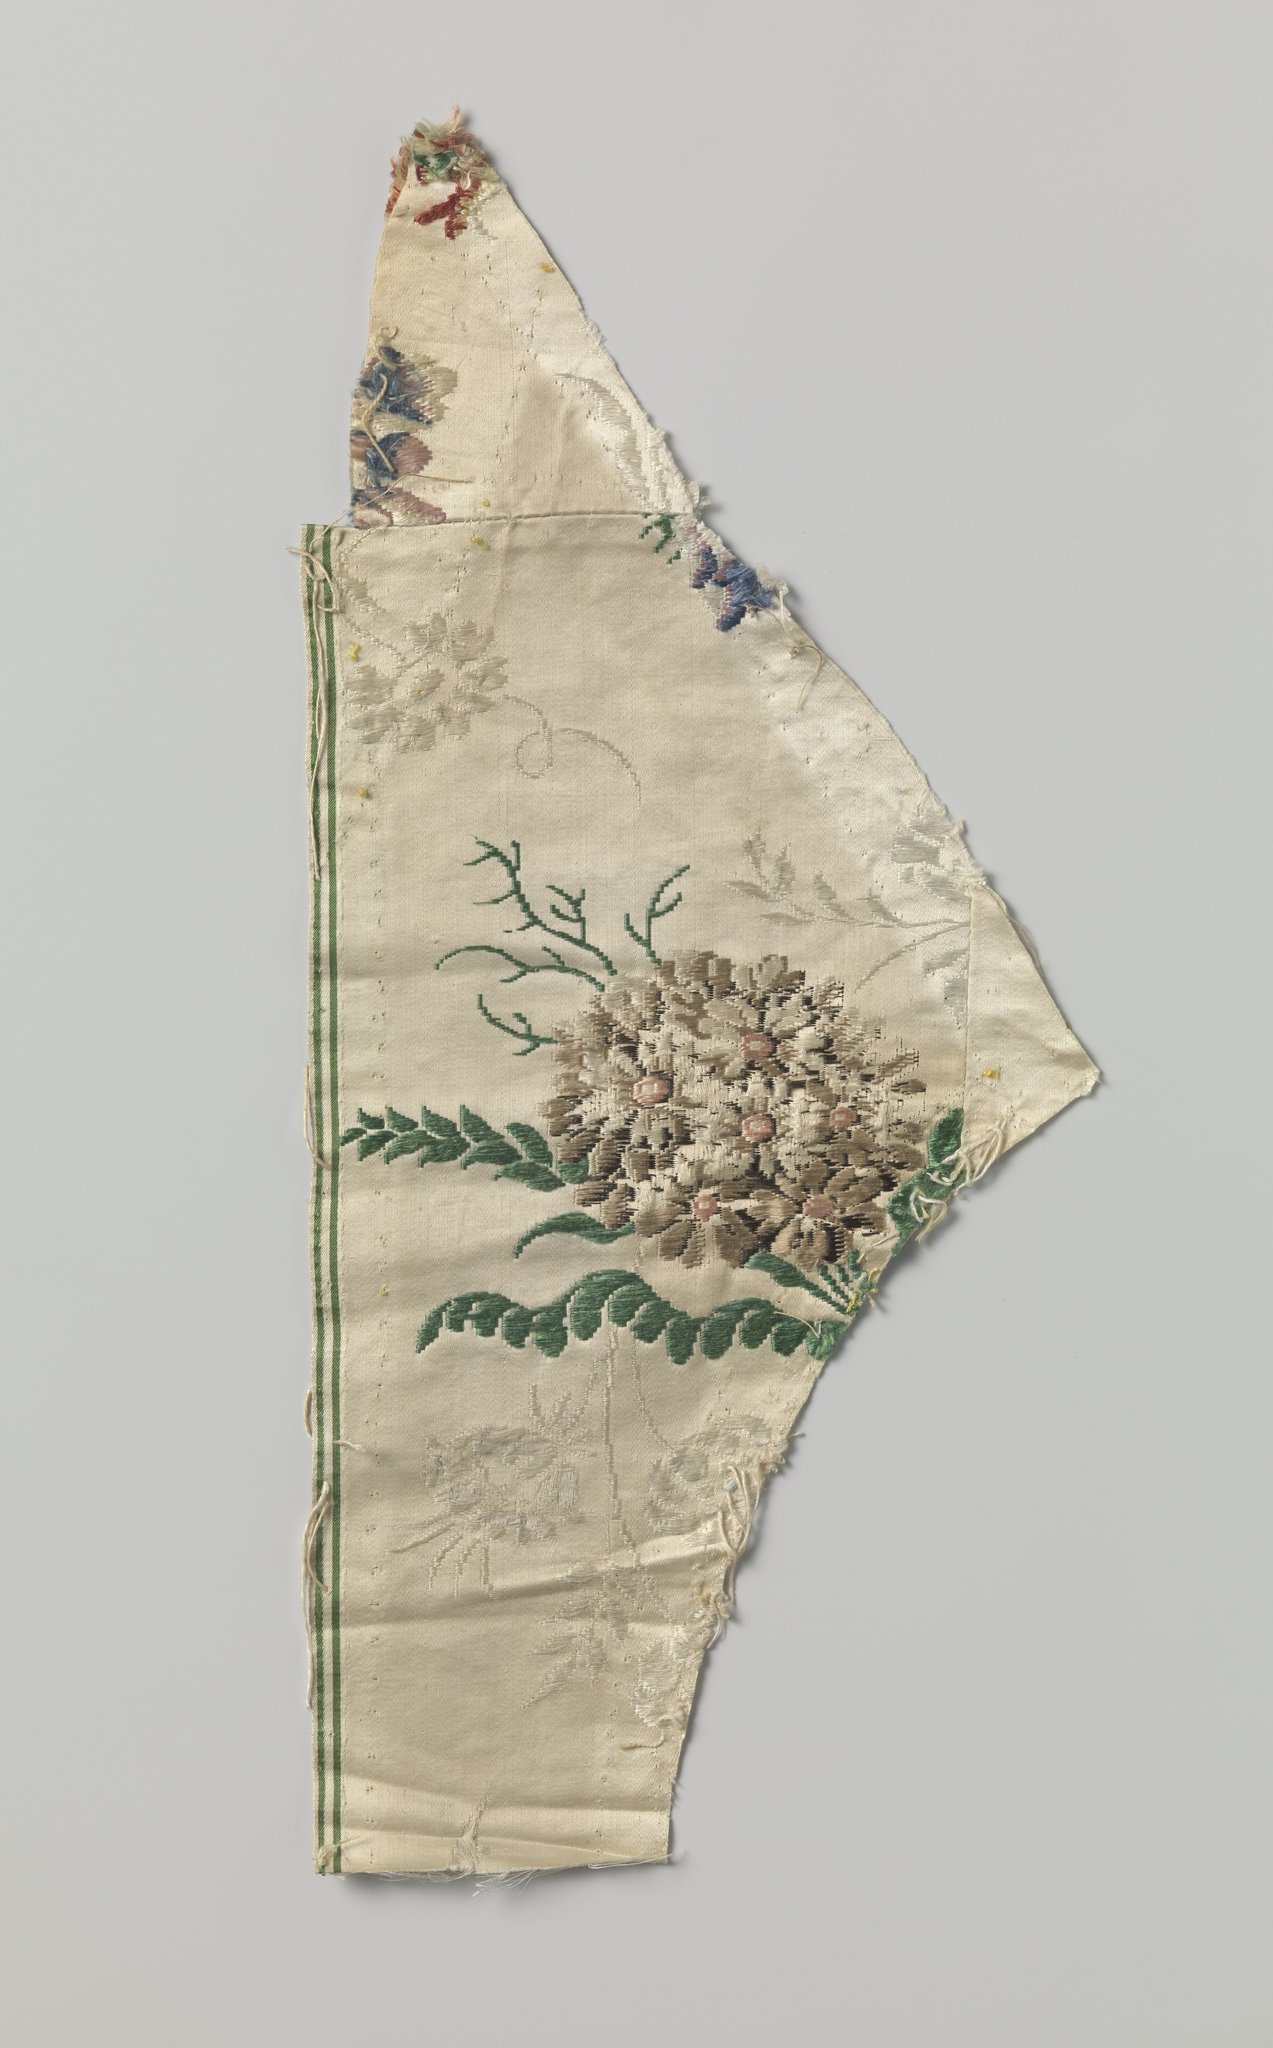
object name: fragment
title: Fragment gebrocheerde zijde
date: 1775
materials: silk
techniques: brocade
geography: europe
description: Fragment zijdeweefsel. Een crèmekleurige satijnen grond heeft witte bloemslingers en een meerkleurig boeket bloemen met bladslingers.